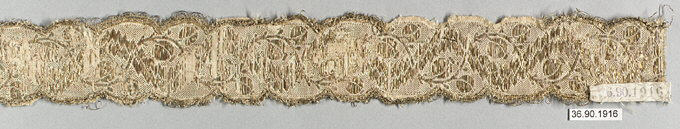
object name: galloon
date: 1801-1900